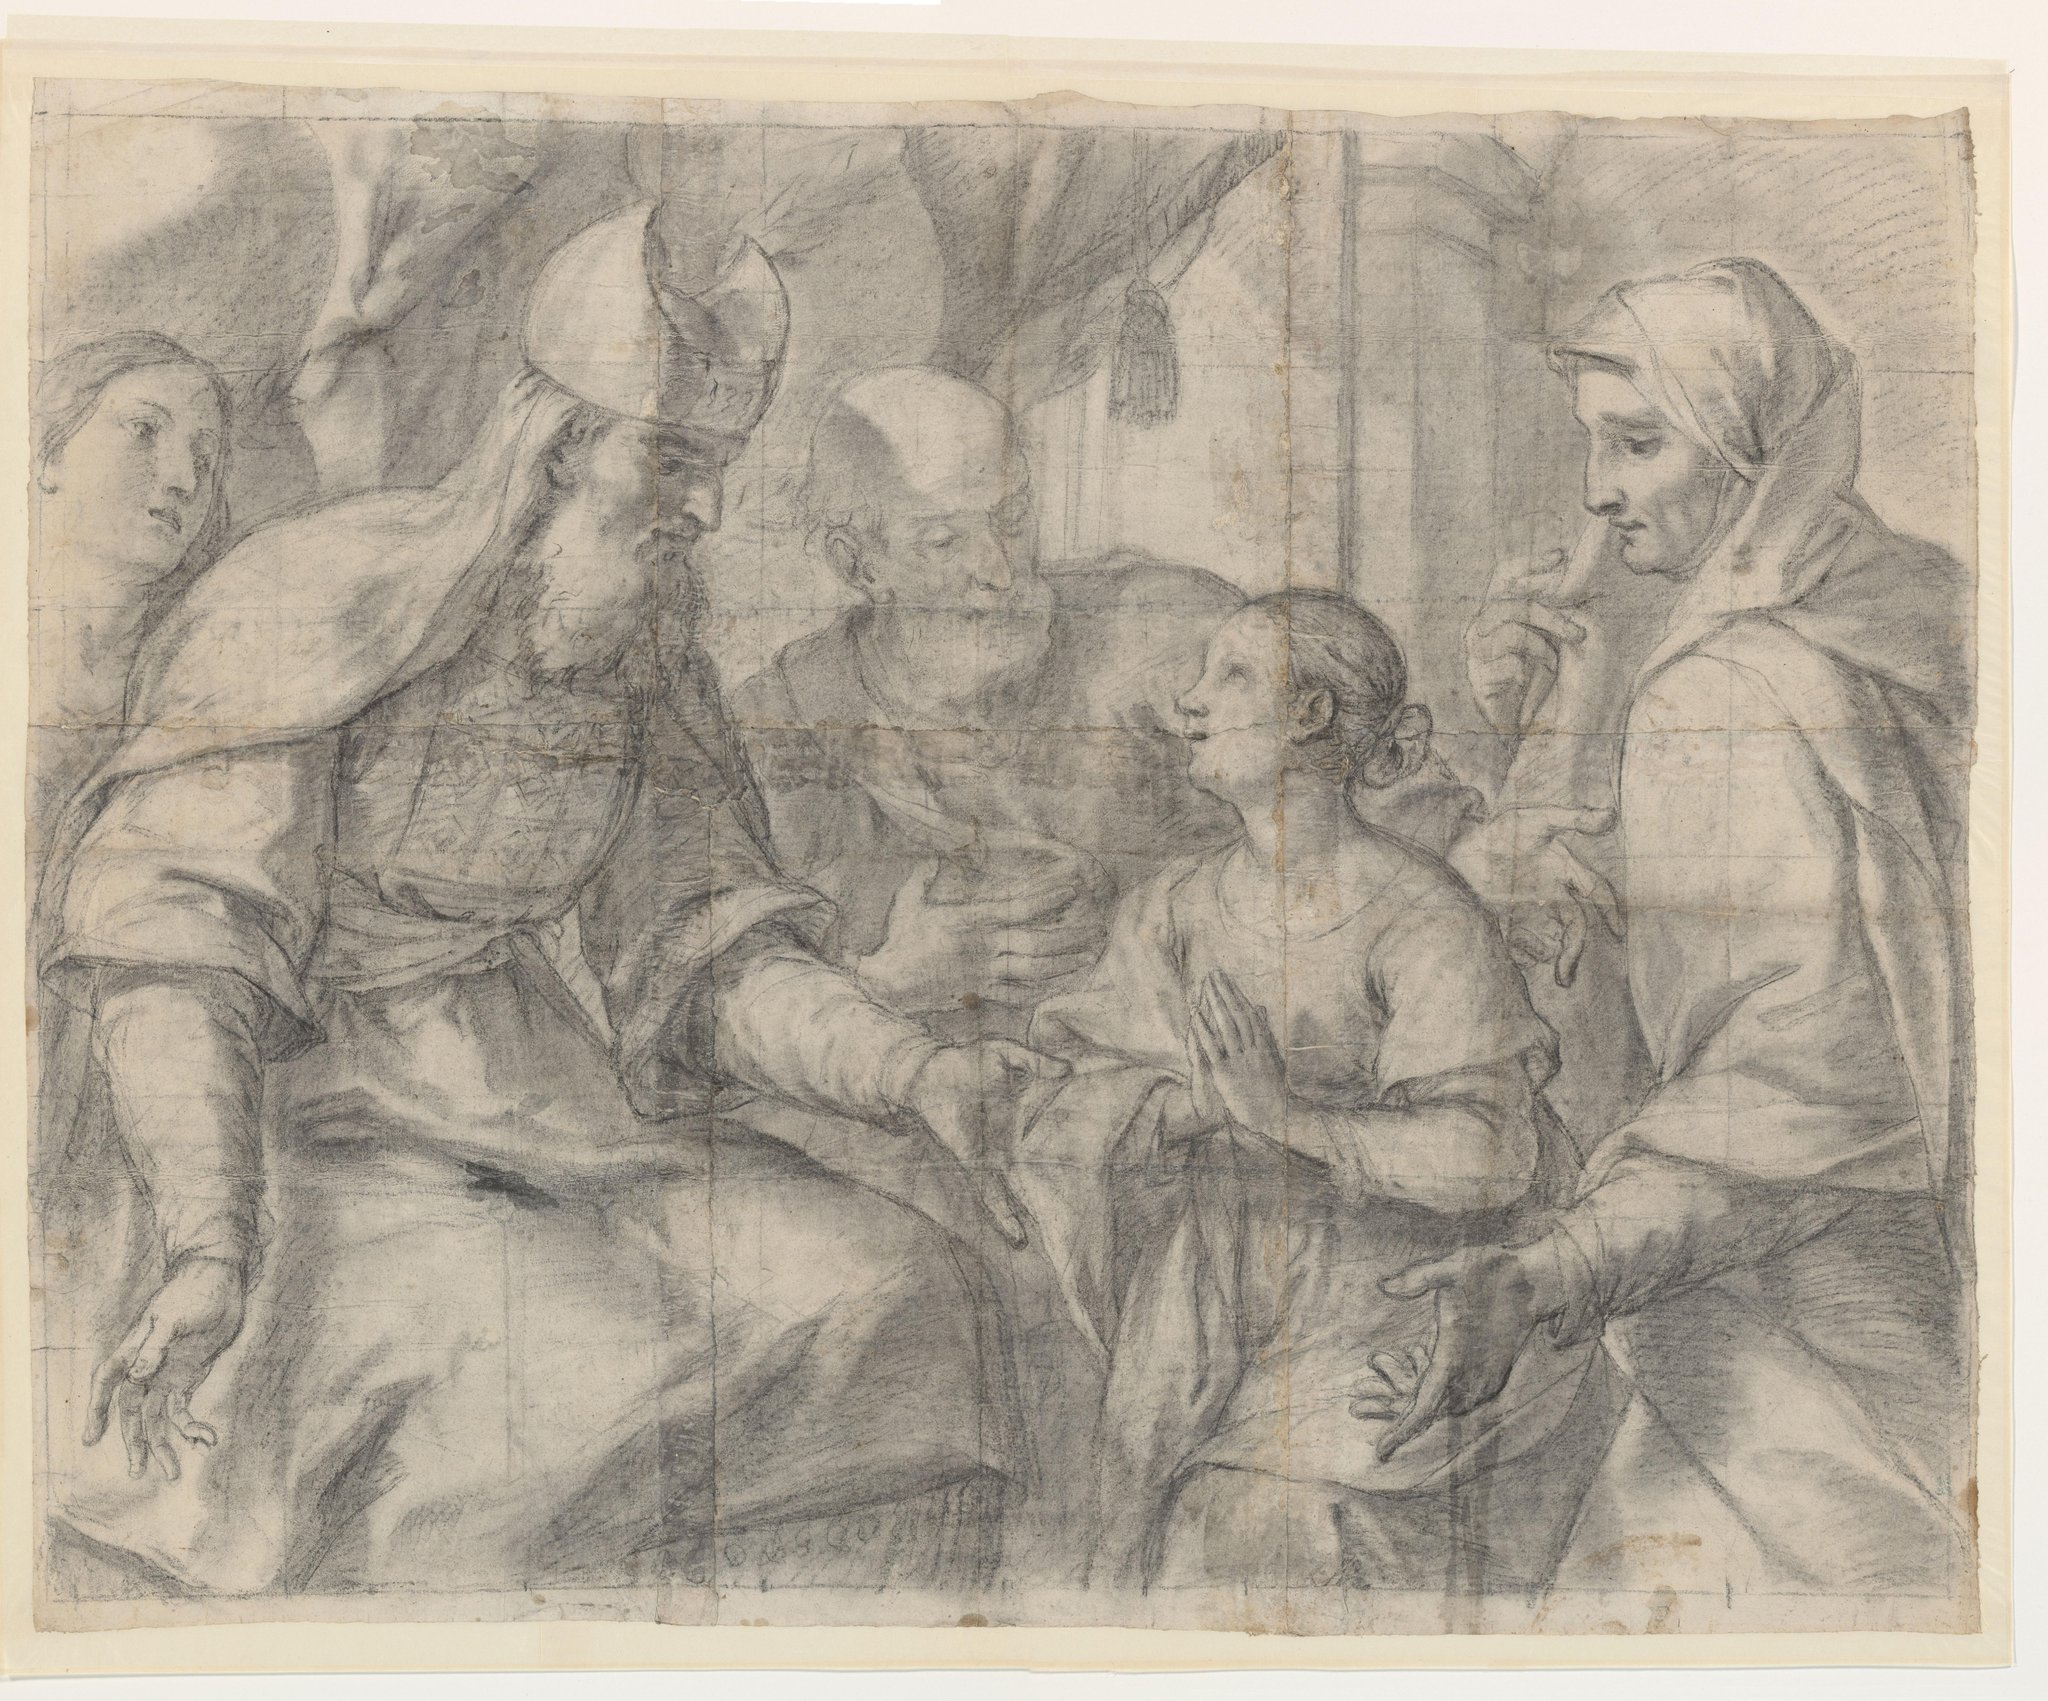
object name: drawing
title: Groot ontwerp voor een tempelgang van Maria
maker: giovanni andrea ansaldo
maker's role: draughtsman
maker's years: 1584-1638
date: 1594-1638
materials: chalk, paper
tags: dedication (or presentation) of mary in the temple: she ascends the steps and is received by the high priest